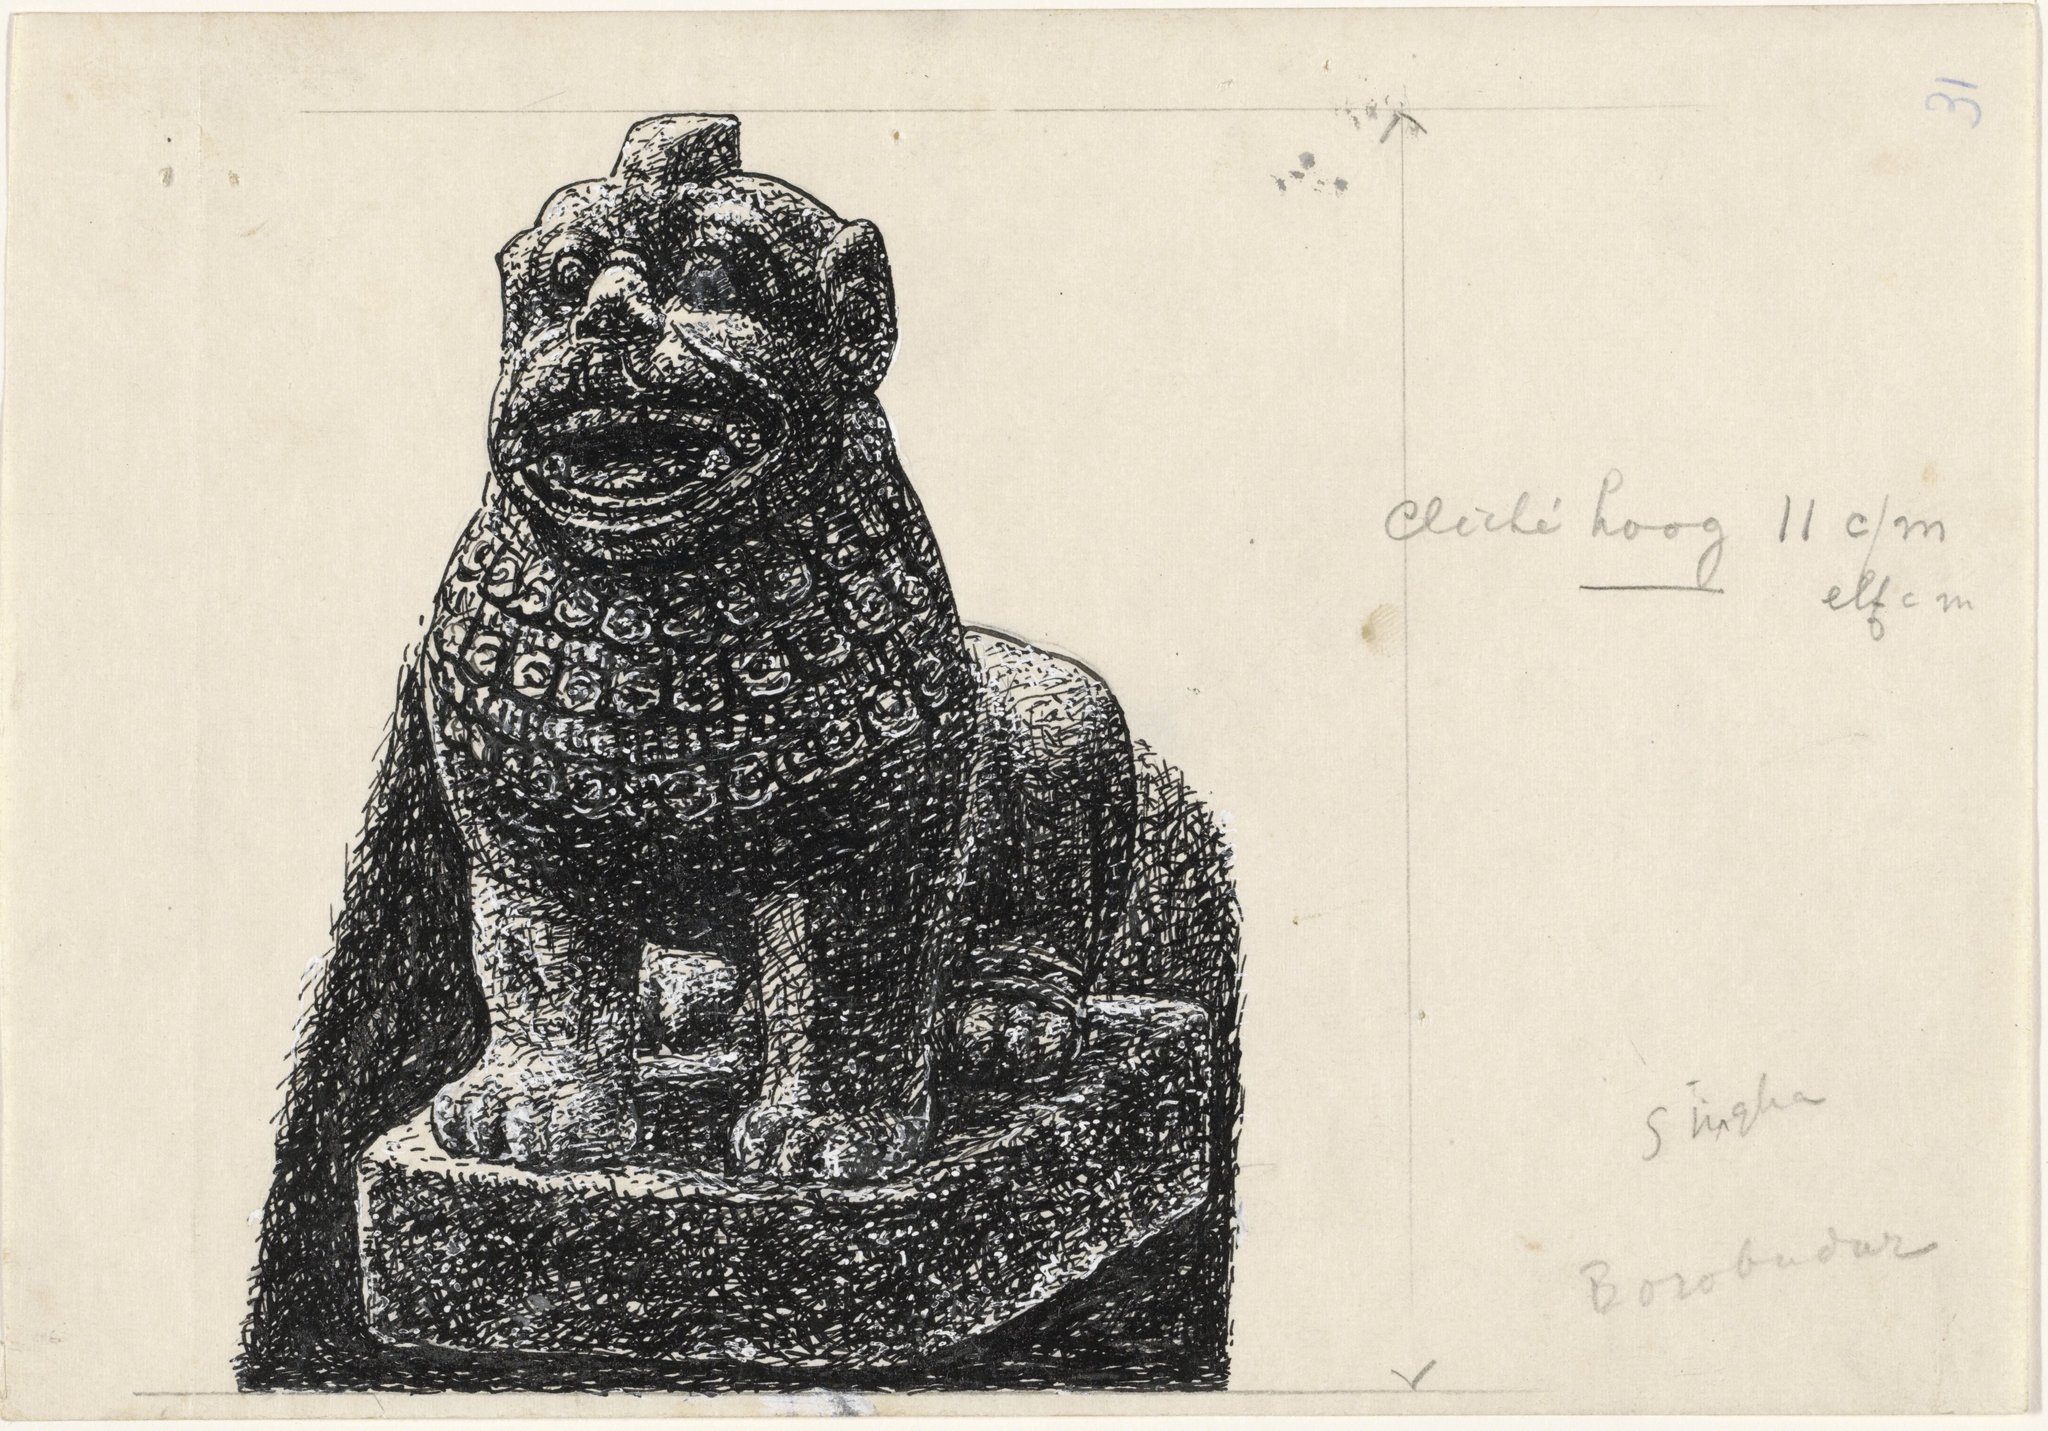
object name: drawing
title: Beeld van een leeuw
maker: leo gestel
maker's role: draughtsman, print maker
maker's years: 1881-1941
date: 1934-1936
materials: paint, ink, paper, pencil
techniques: pen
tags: (cohen, van anarchist tot monarchist) specific works of literature (with author, title), other holy places ~ non-christian religions, (other) historical names, statues, paintings, etc. ~ objects of worship (non-christian religions) - bb - in the open air, java, indonesia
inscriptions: clichéaanwijzing, recto, handgeschreven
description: Ontwerp voor een boekillustratie voor: Cohen, Alexander. Van anarchist tot monarchist. Amsterdam: De Steenuil, 1936.